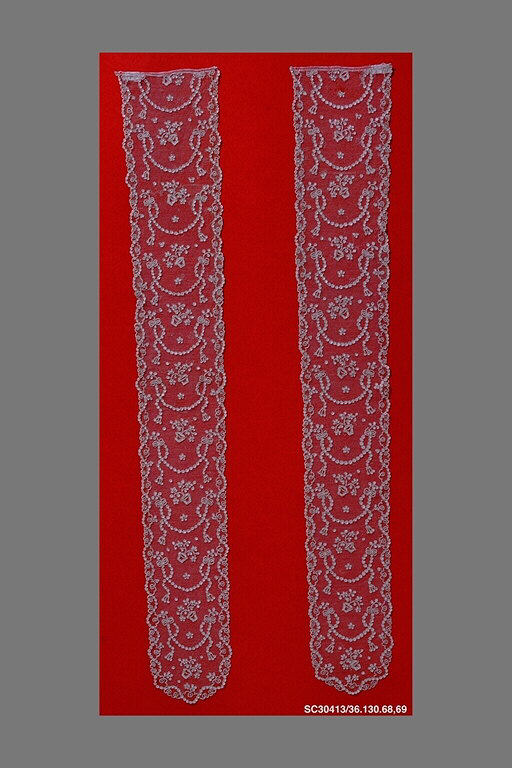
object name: lappet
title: Lappets (one of a pair)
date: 1776-1800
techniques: lace